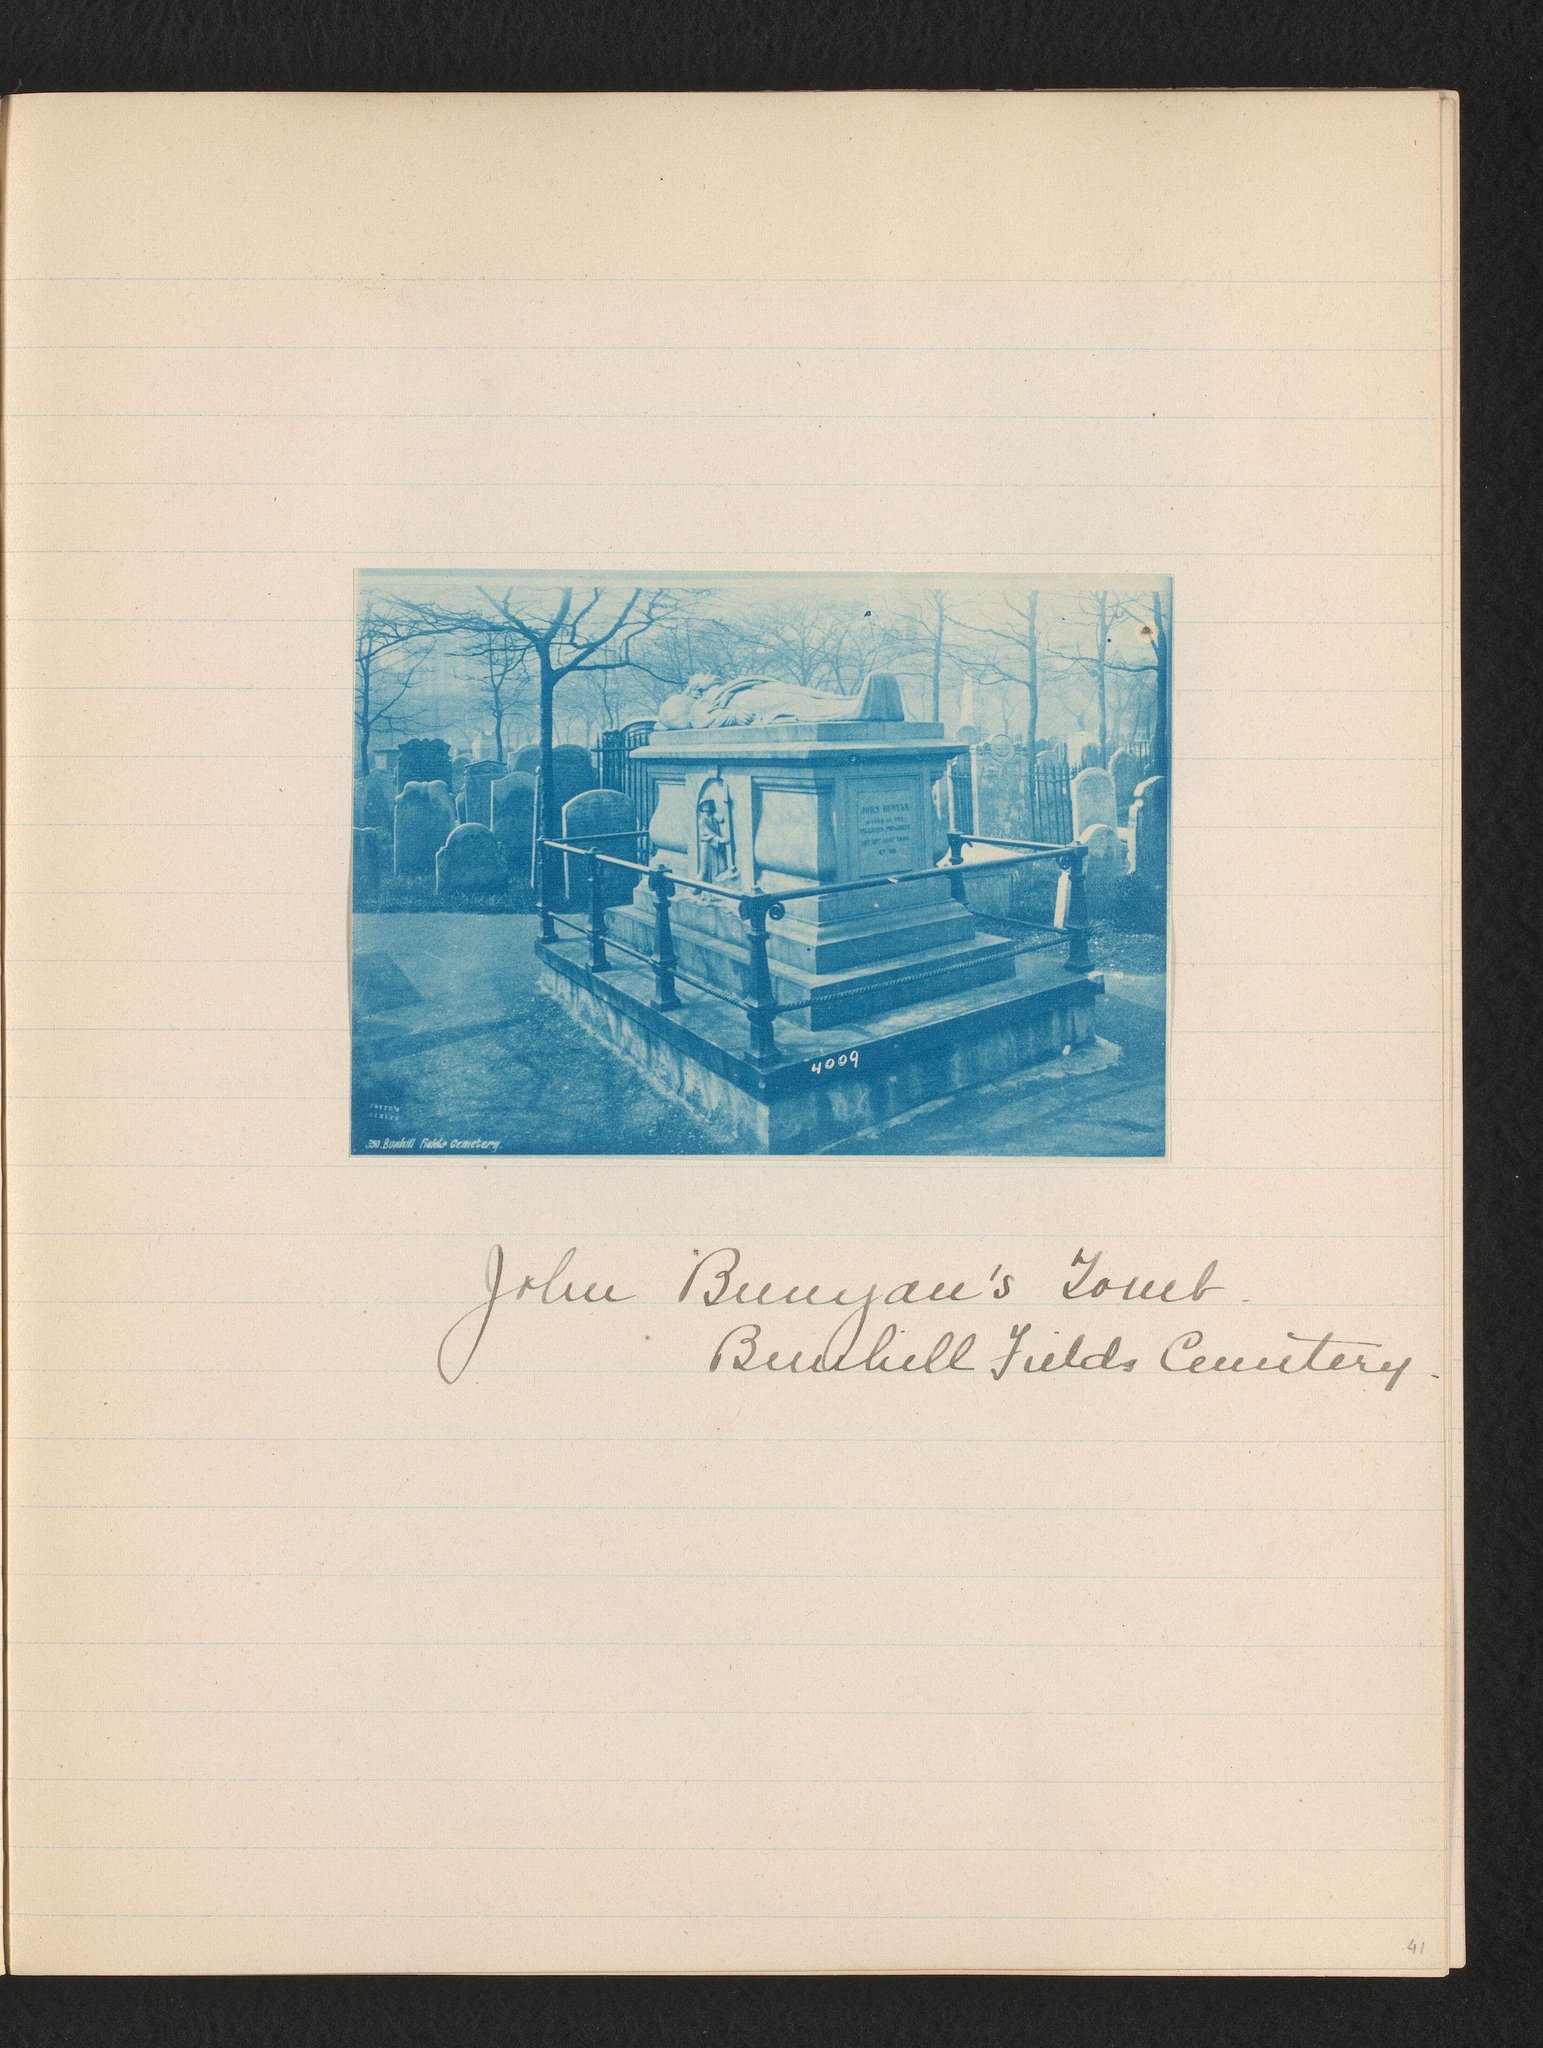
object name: photograph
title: Graf van John Bunyan op de Bunhill Fields Cemetery, Londen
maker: francis frith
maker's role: publisher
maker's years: 1822-1898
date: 1890-1901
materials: paper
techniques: cyanotype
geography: london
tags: grave, tomb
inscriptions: inscription: ‘Frith's Series/ 350 Bunhill Fields Cemetery’